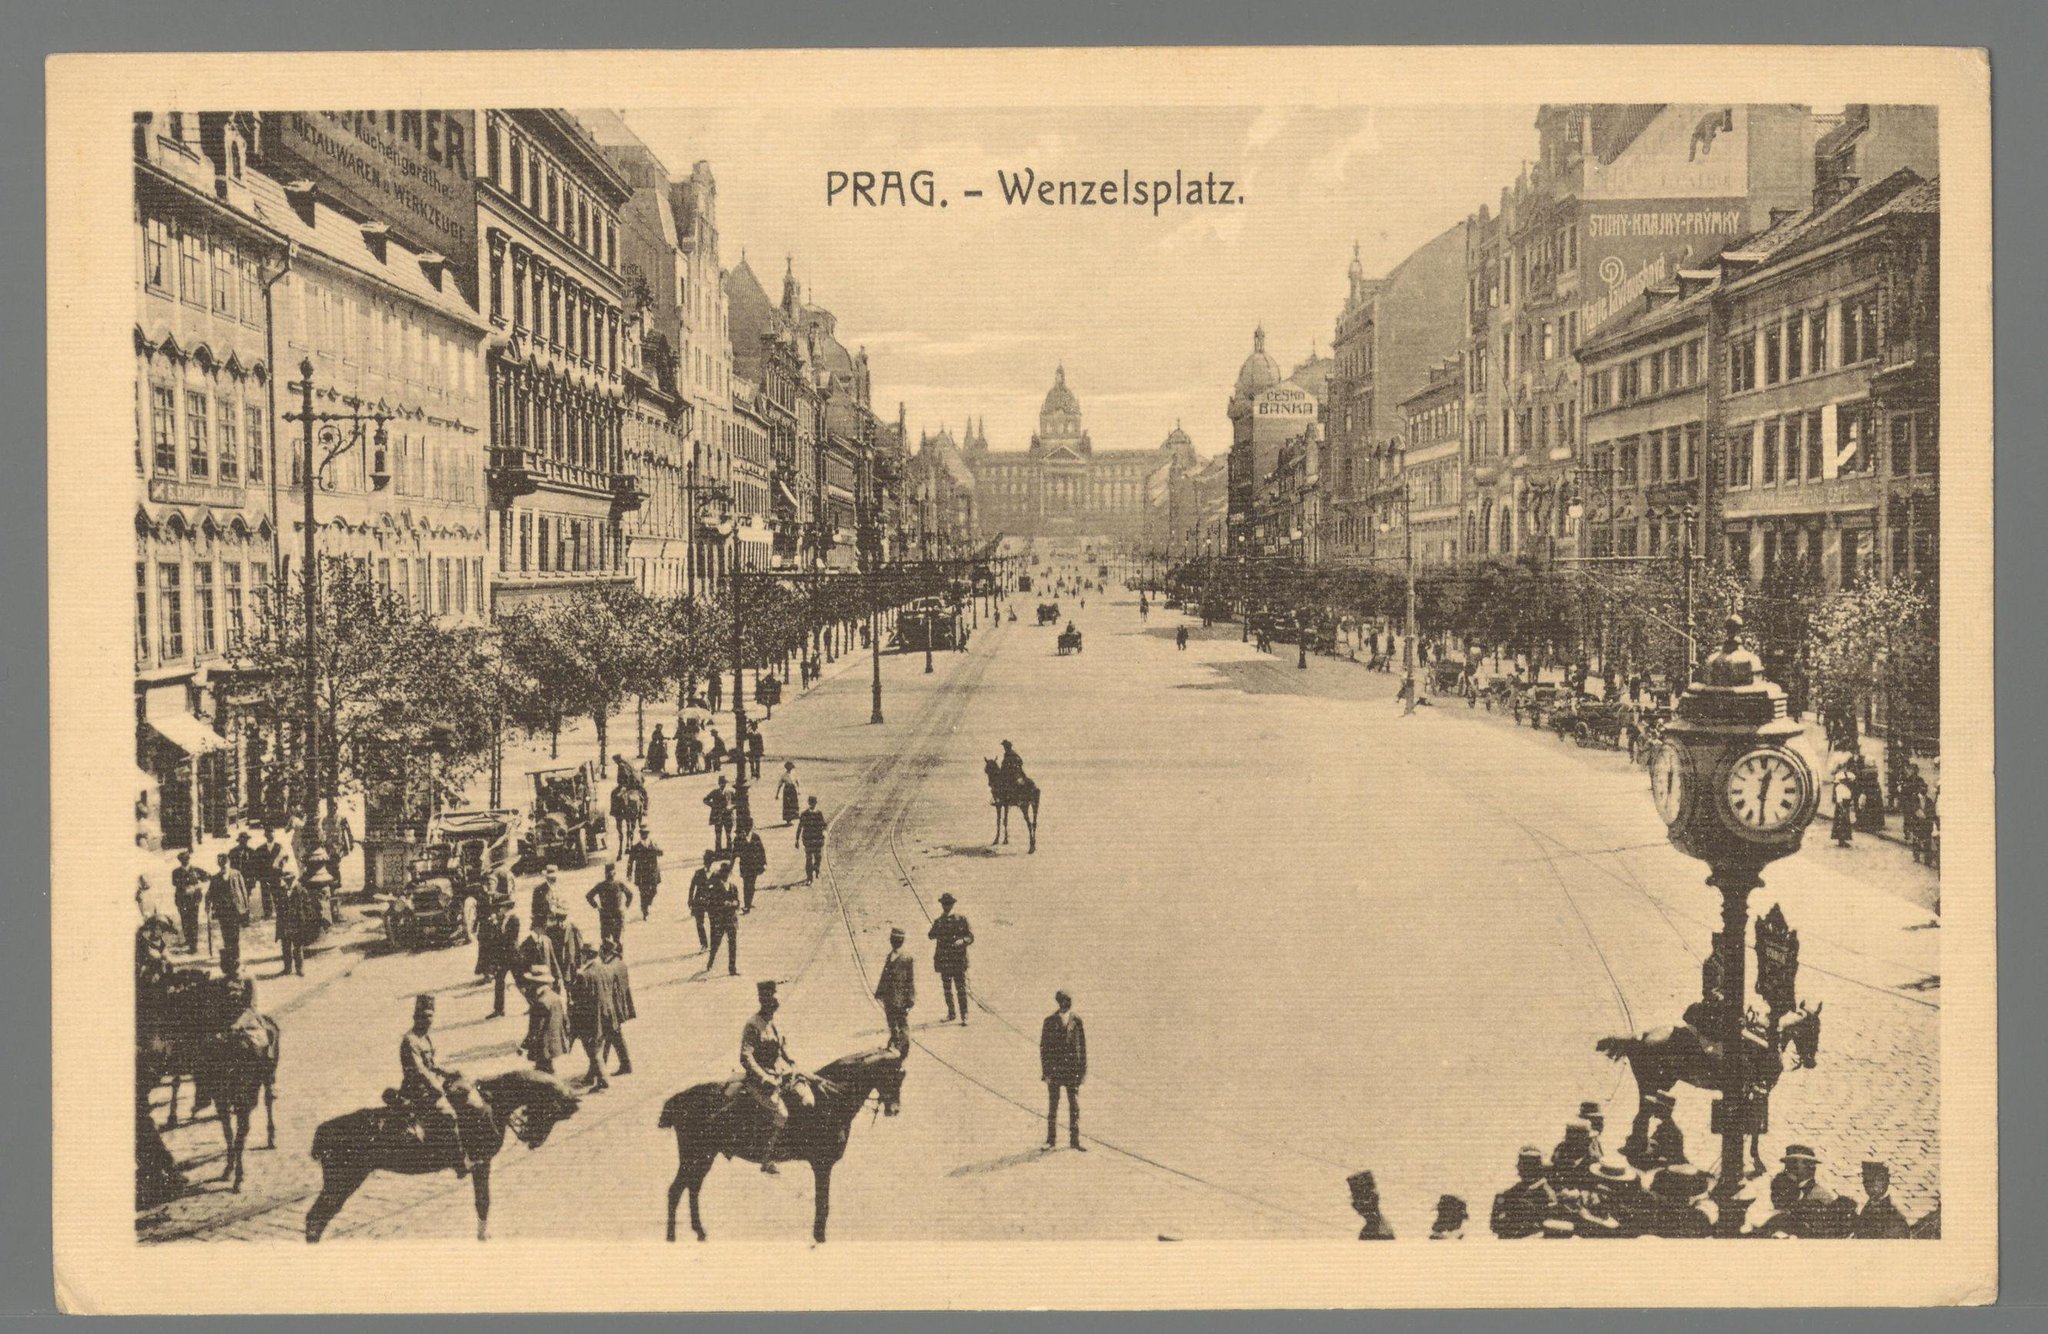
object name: photomechanical print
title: Prag - Wenzelsplatz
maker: Anonymous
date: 1906-1920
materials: cardboard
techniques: photograph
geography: prague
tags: shop, store, square, place, circus, etc.